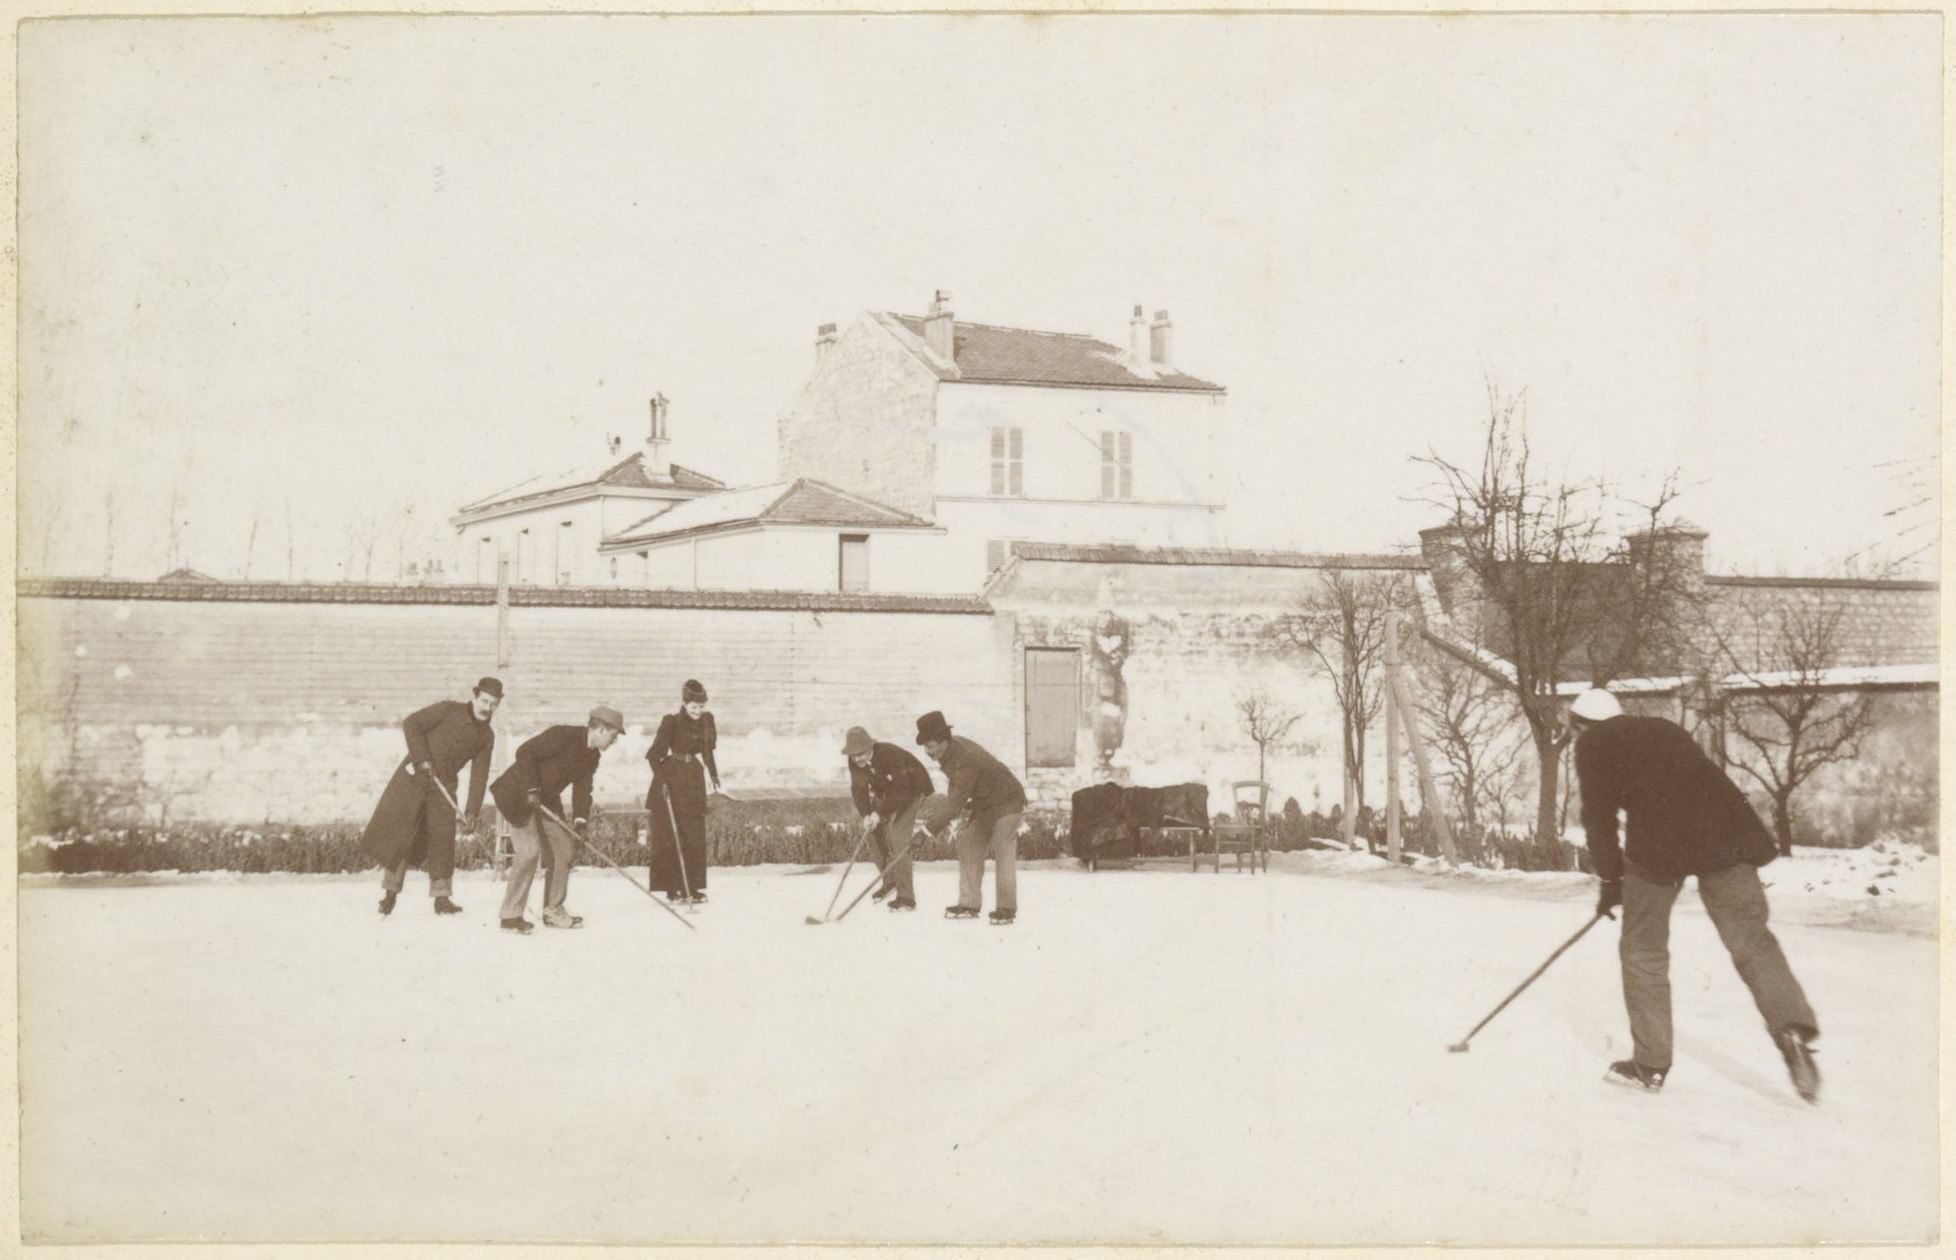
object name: photograph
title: IJshockeyspelend gezelschap, vermoedelijk in Frankrijk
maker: Anonymous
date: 1900-1910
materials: paper, photographic support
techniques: daylight paper print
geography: france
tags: ice hockey, skates (winter sports), france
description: Onderdeel van Fotoalbum van een Franse amateurfotograaf met opnames van een familie, distilleerderij Delizy & Doistau Fils, het leger en bezienswaardigheden in Frankrijk.